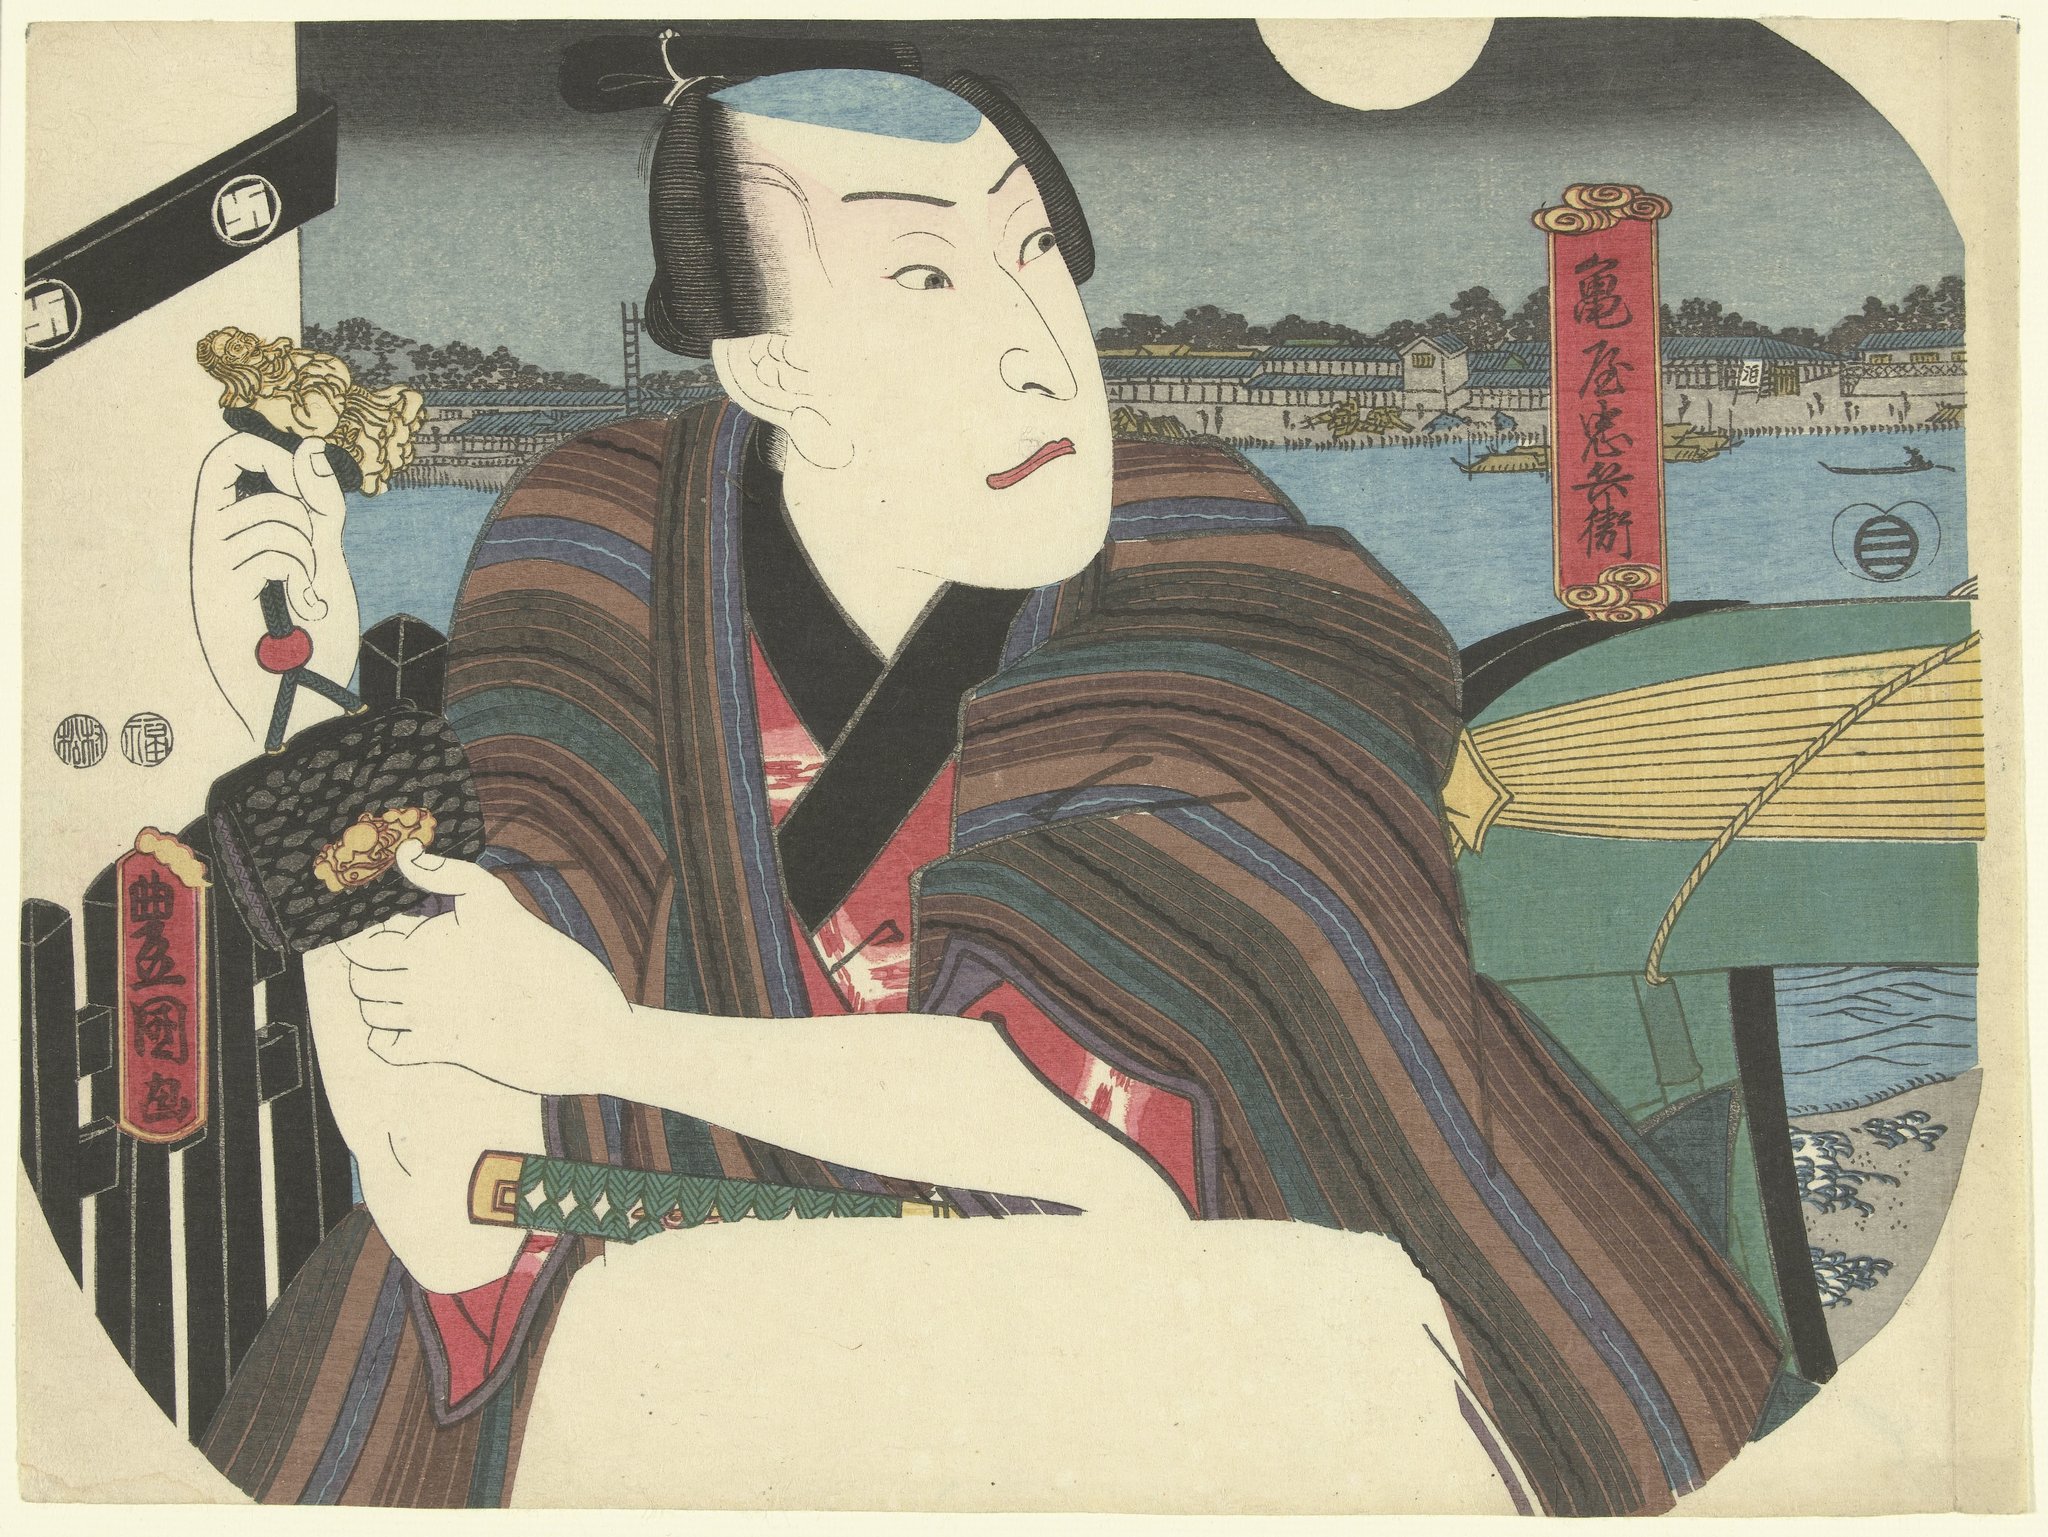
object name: print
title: Samoerai bij rivier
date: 1850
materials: paper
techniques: woodcut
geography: japan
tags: river, adult man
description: Waaierprent waarop samoerai, vasthoudende een inro waaraan netsuke in de vorm van een mens, opzij kijkend in de richting van draagstoel; nachtelijke rivieroever op achtergrond.